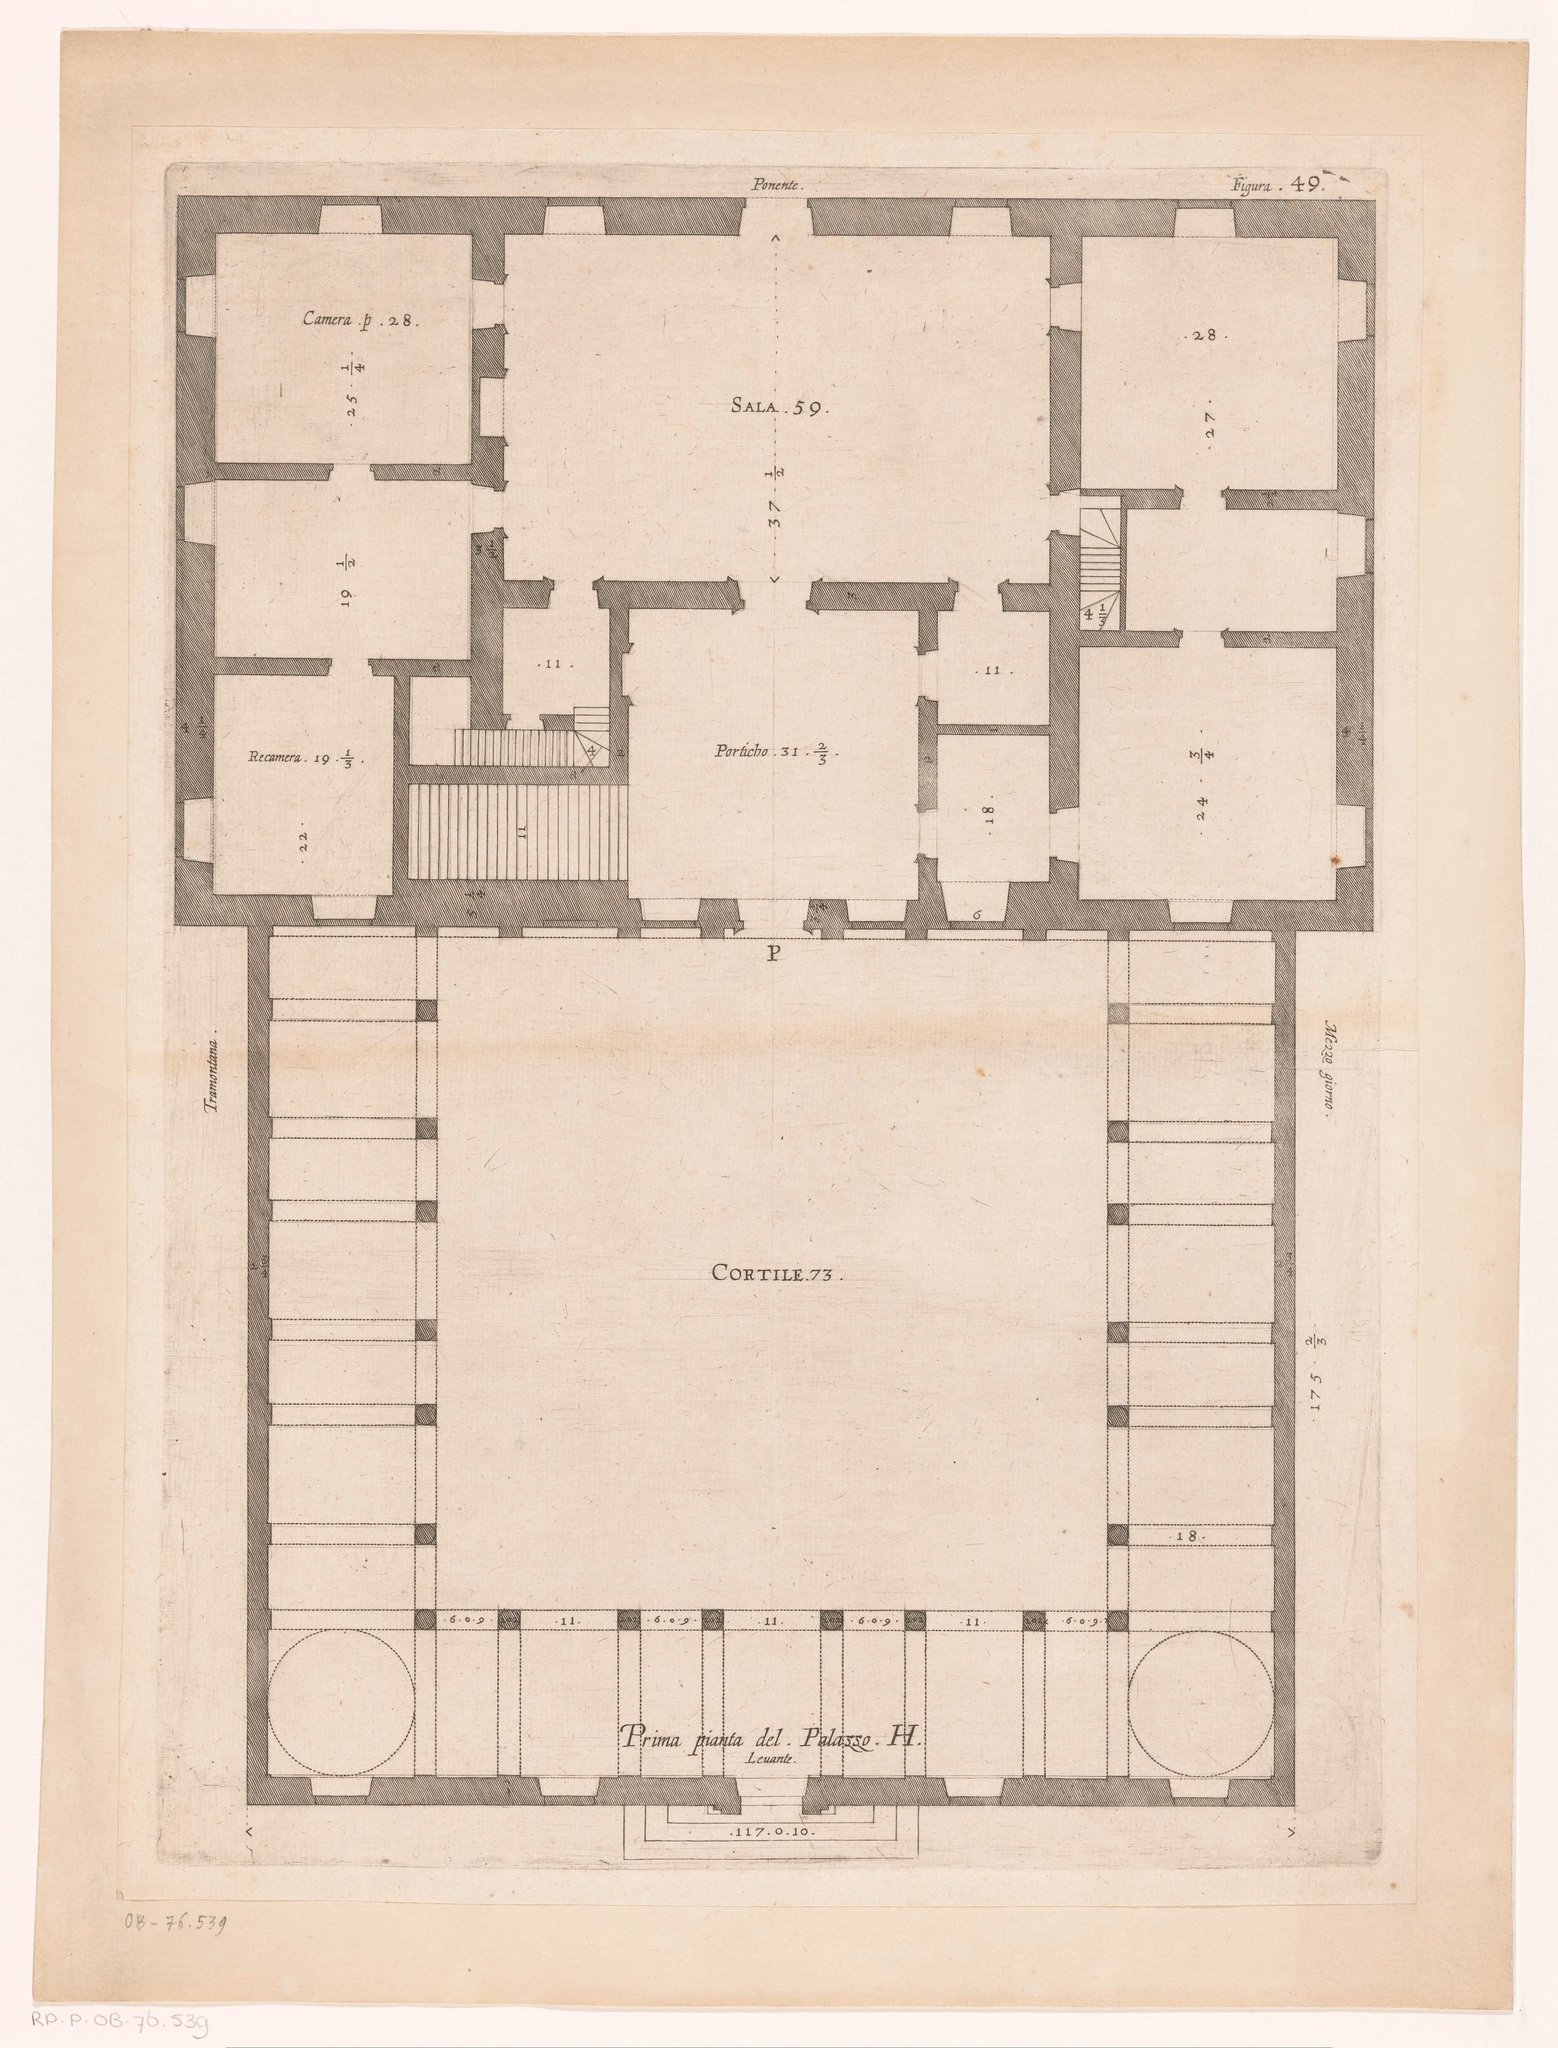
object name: print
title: Plattegrond van de begane grond van de Villa Grimaldi-Sauli te Genua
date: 1622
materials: paper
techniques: engraving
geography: antwerp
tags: hôtel, i.e. small palace in city - aa - civic architecture: inside, plan ~ architecture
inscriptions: collector's mark: Lugt 240